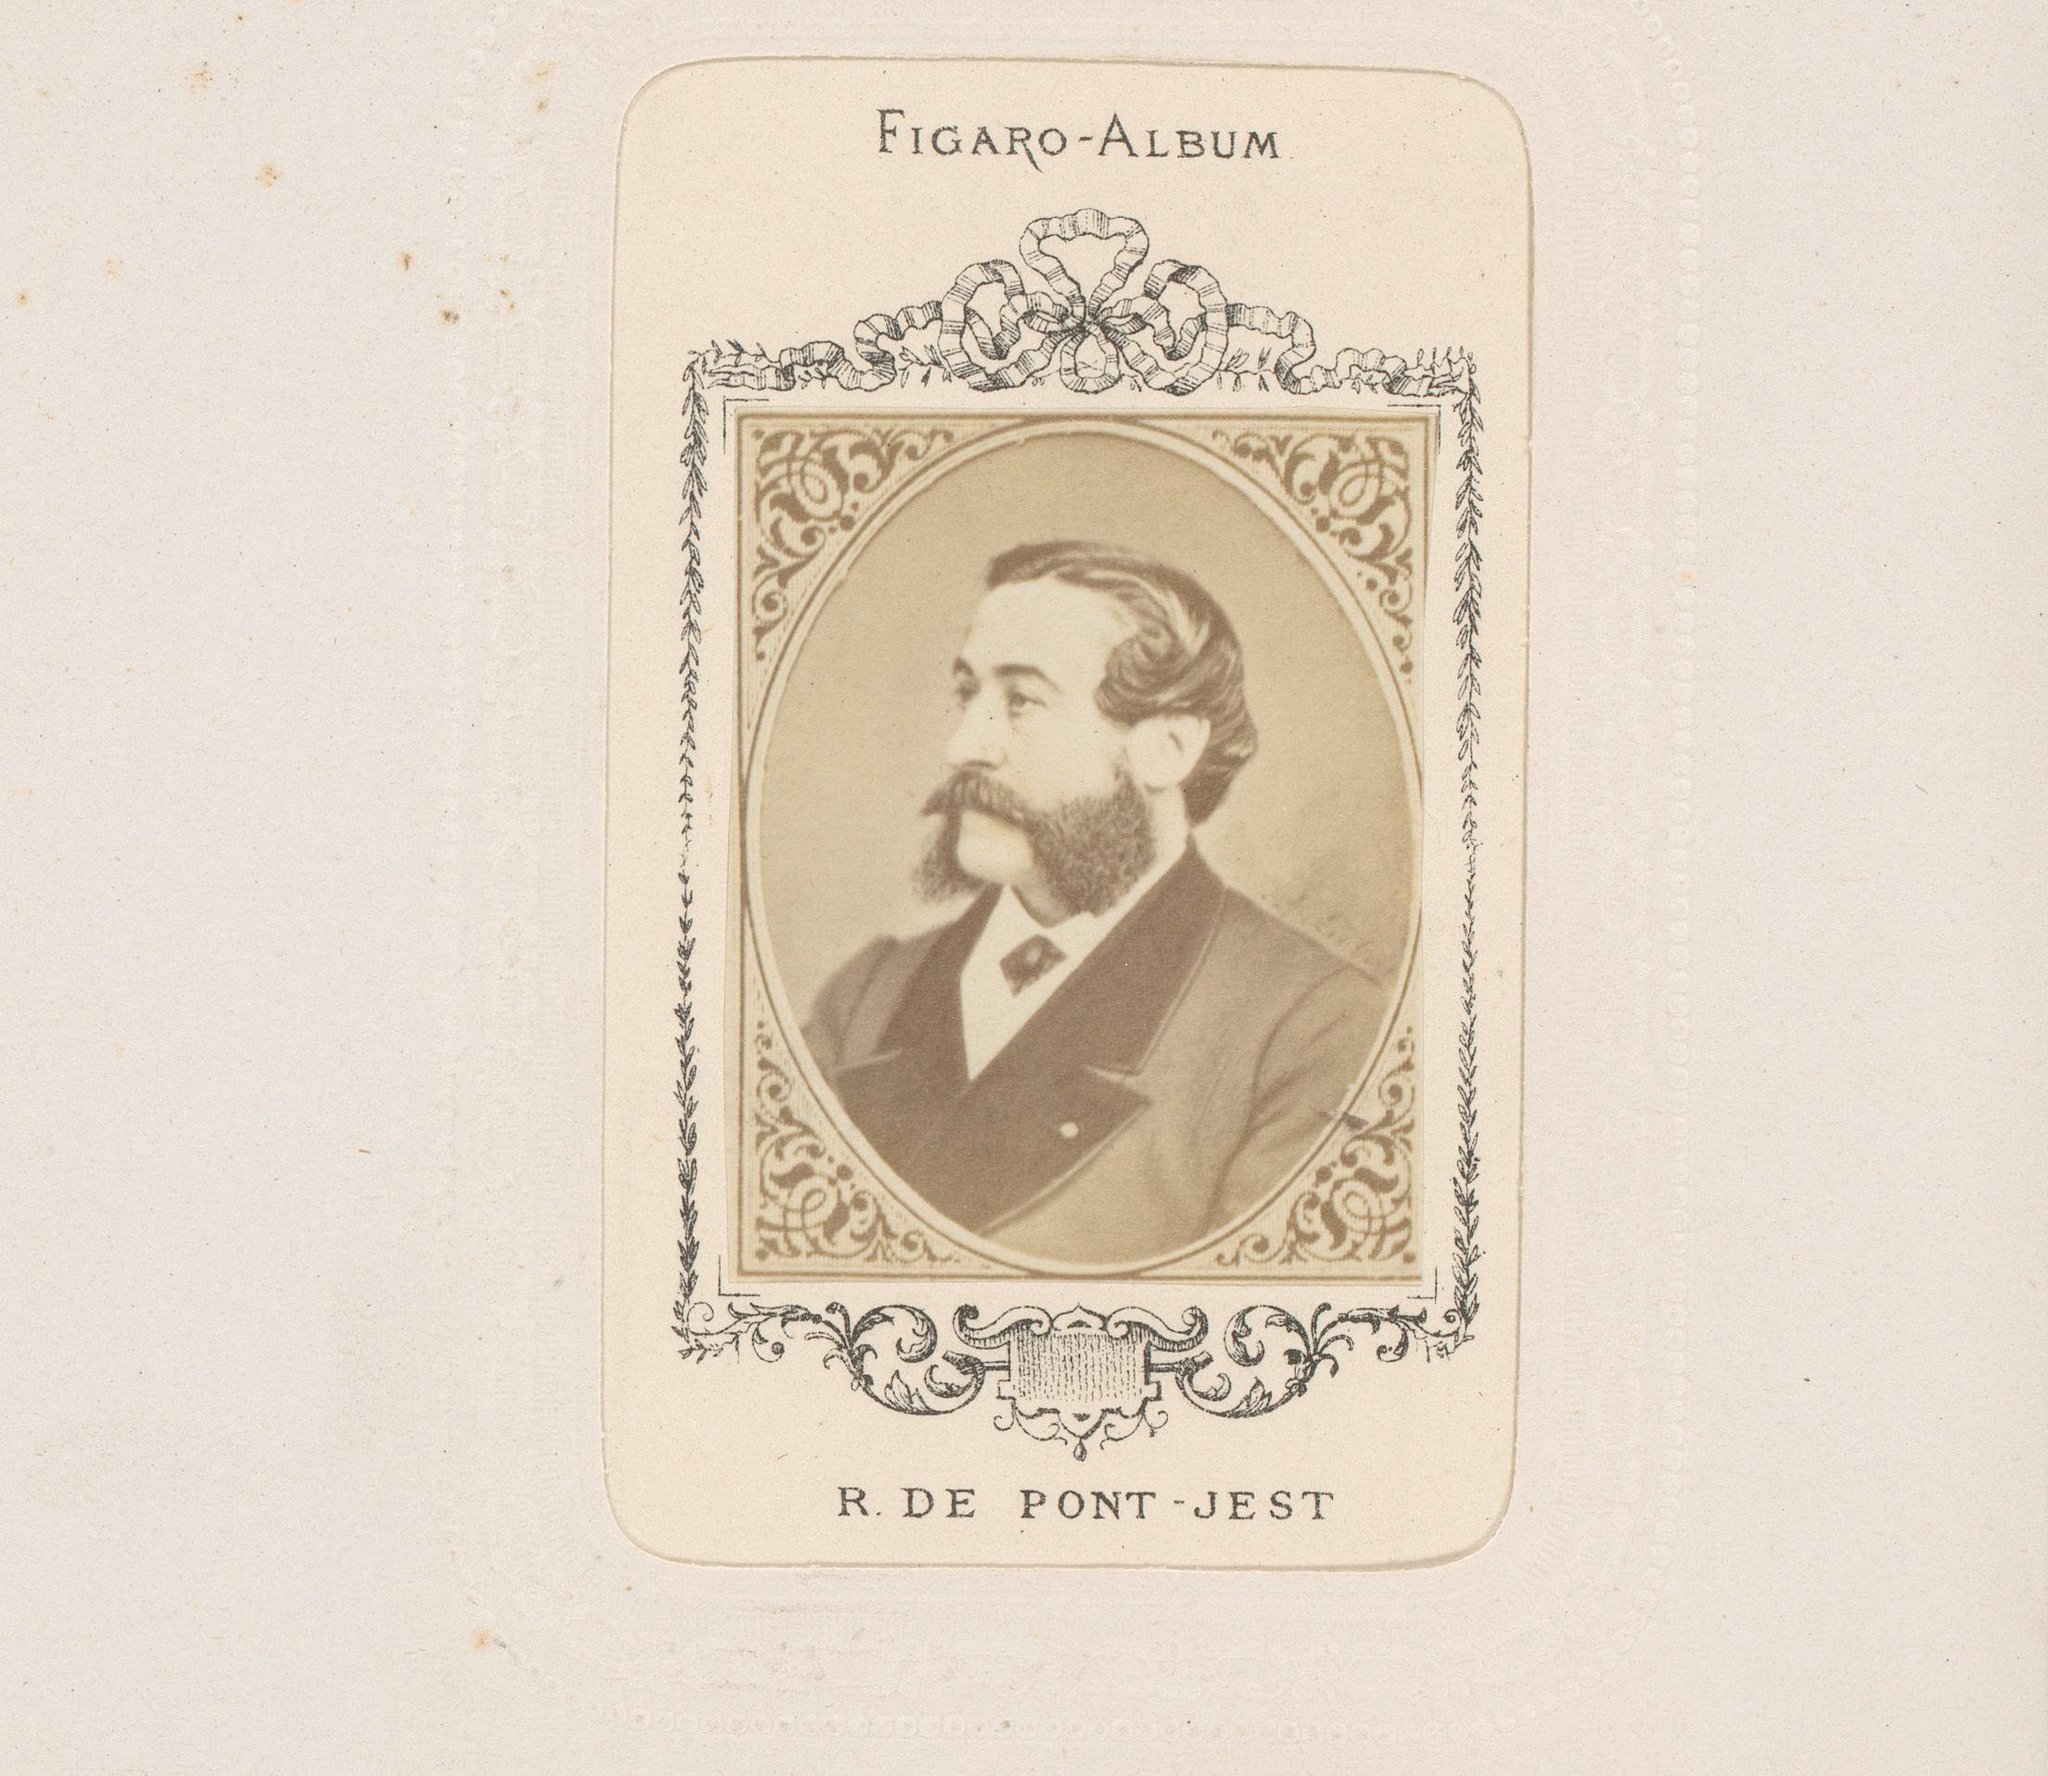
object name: carte de visite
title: Fotoreproductie van een portret van René de Pont-Jest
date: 1860-1900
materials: cardboard, photographic support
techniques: albumen print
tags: paris, journalist, reporter, historical persons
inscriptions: inscription: ‘Figaro-Album/ R. de Pont-Jest/ Liébert Phot.’